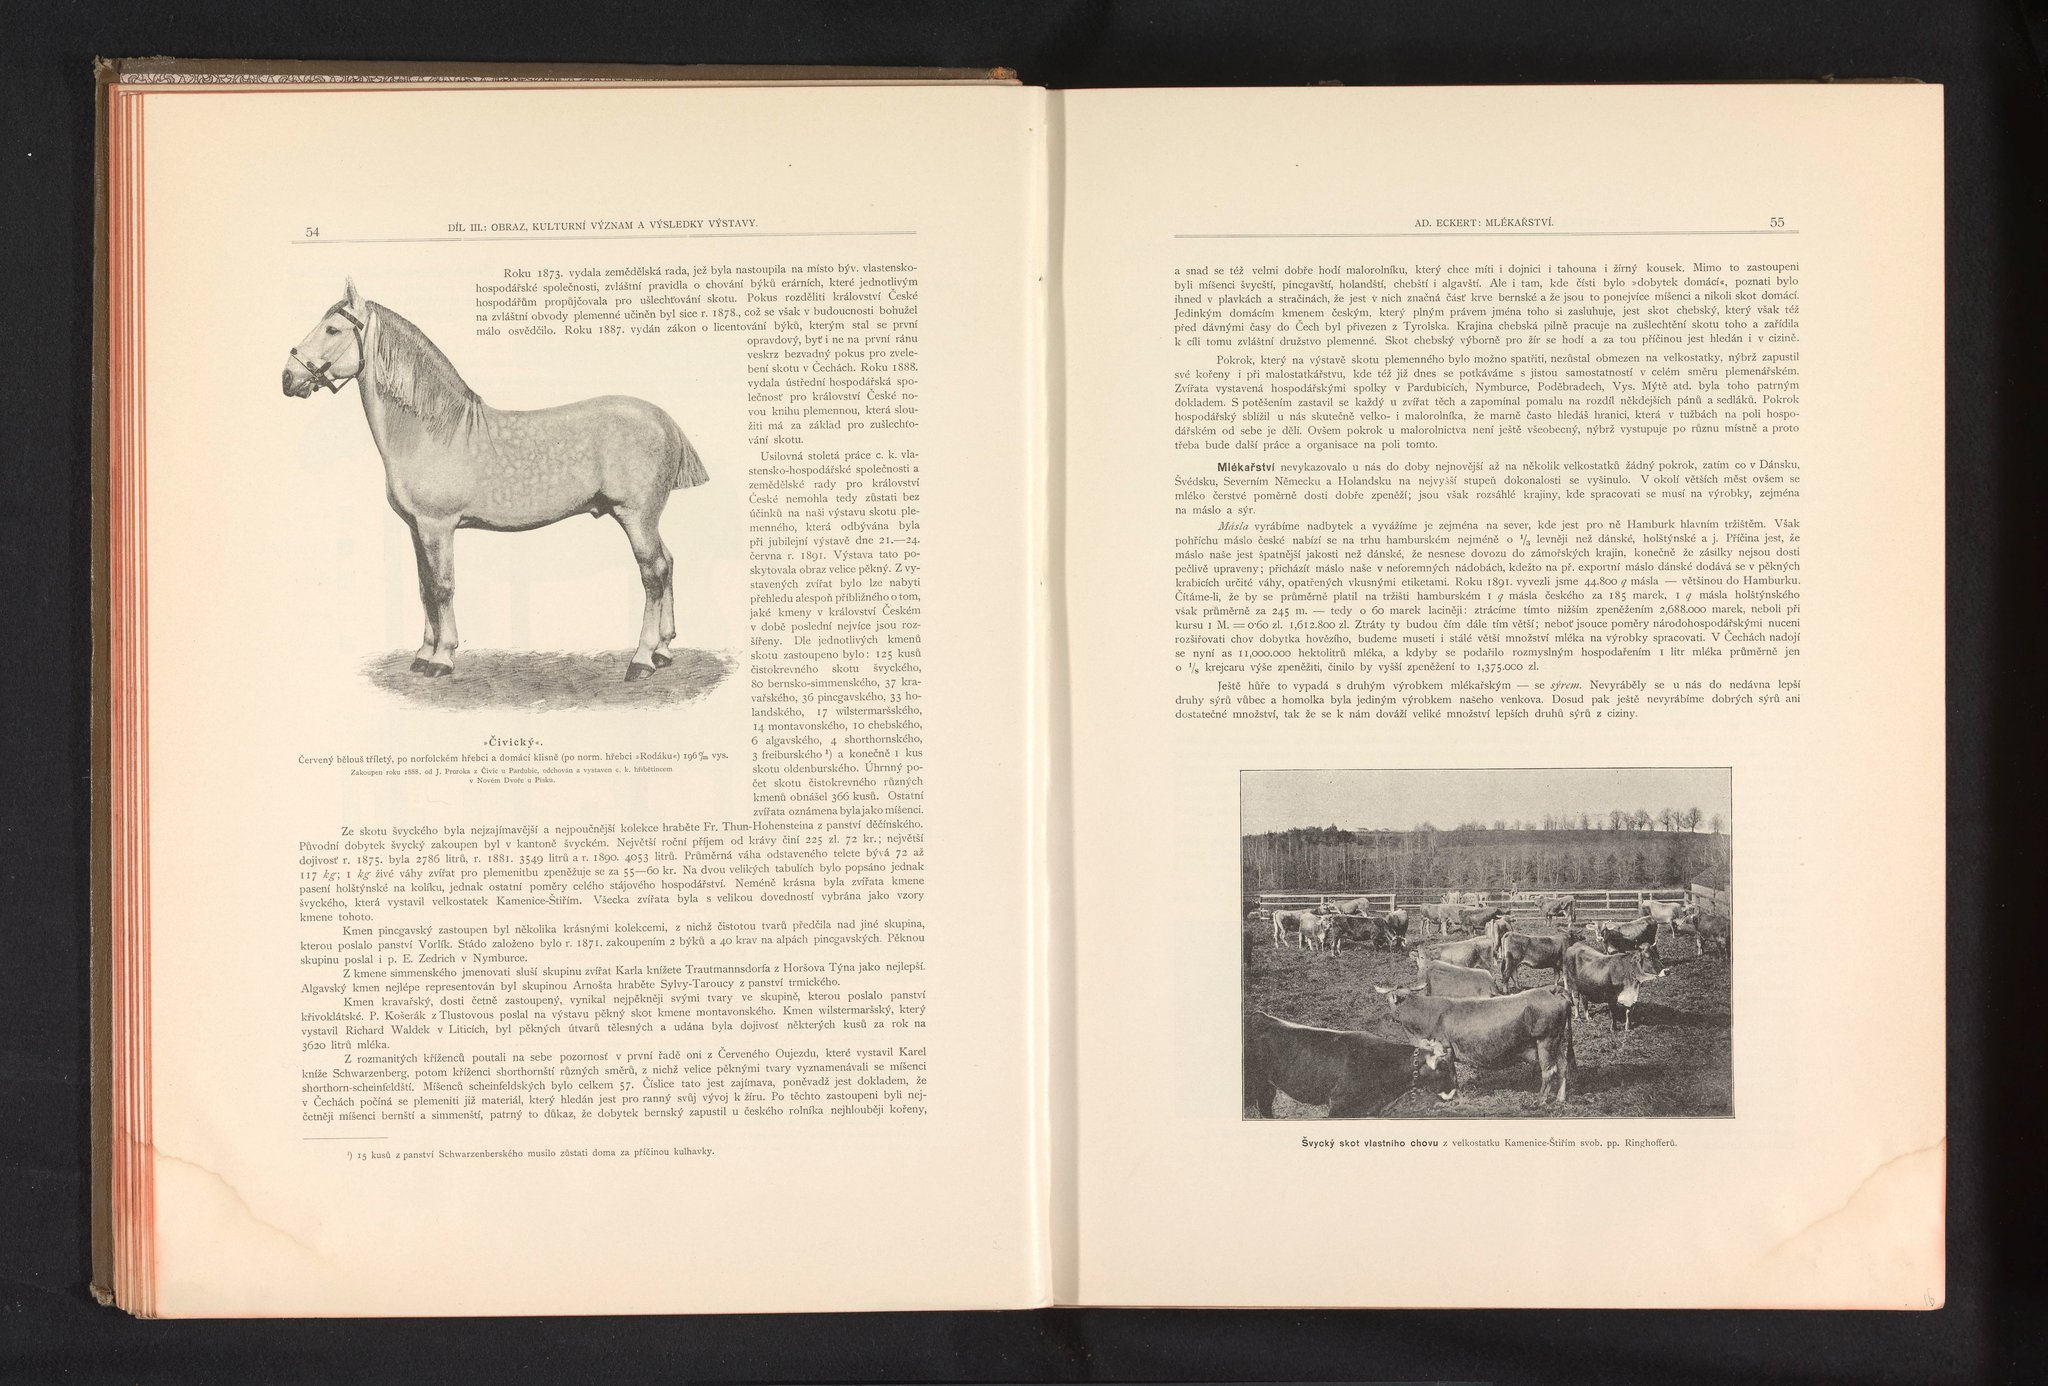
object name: photomechanical print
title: Paard, genaamd Civický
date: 1891-1895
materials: paper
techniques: autotype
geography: prague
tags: horse